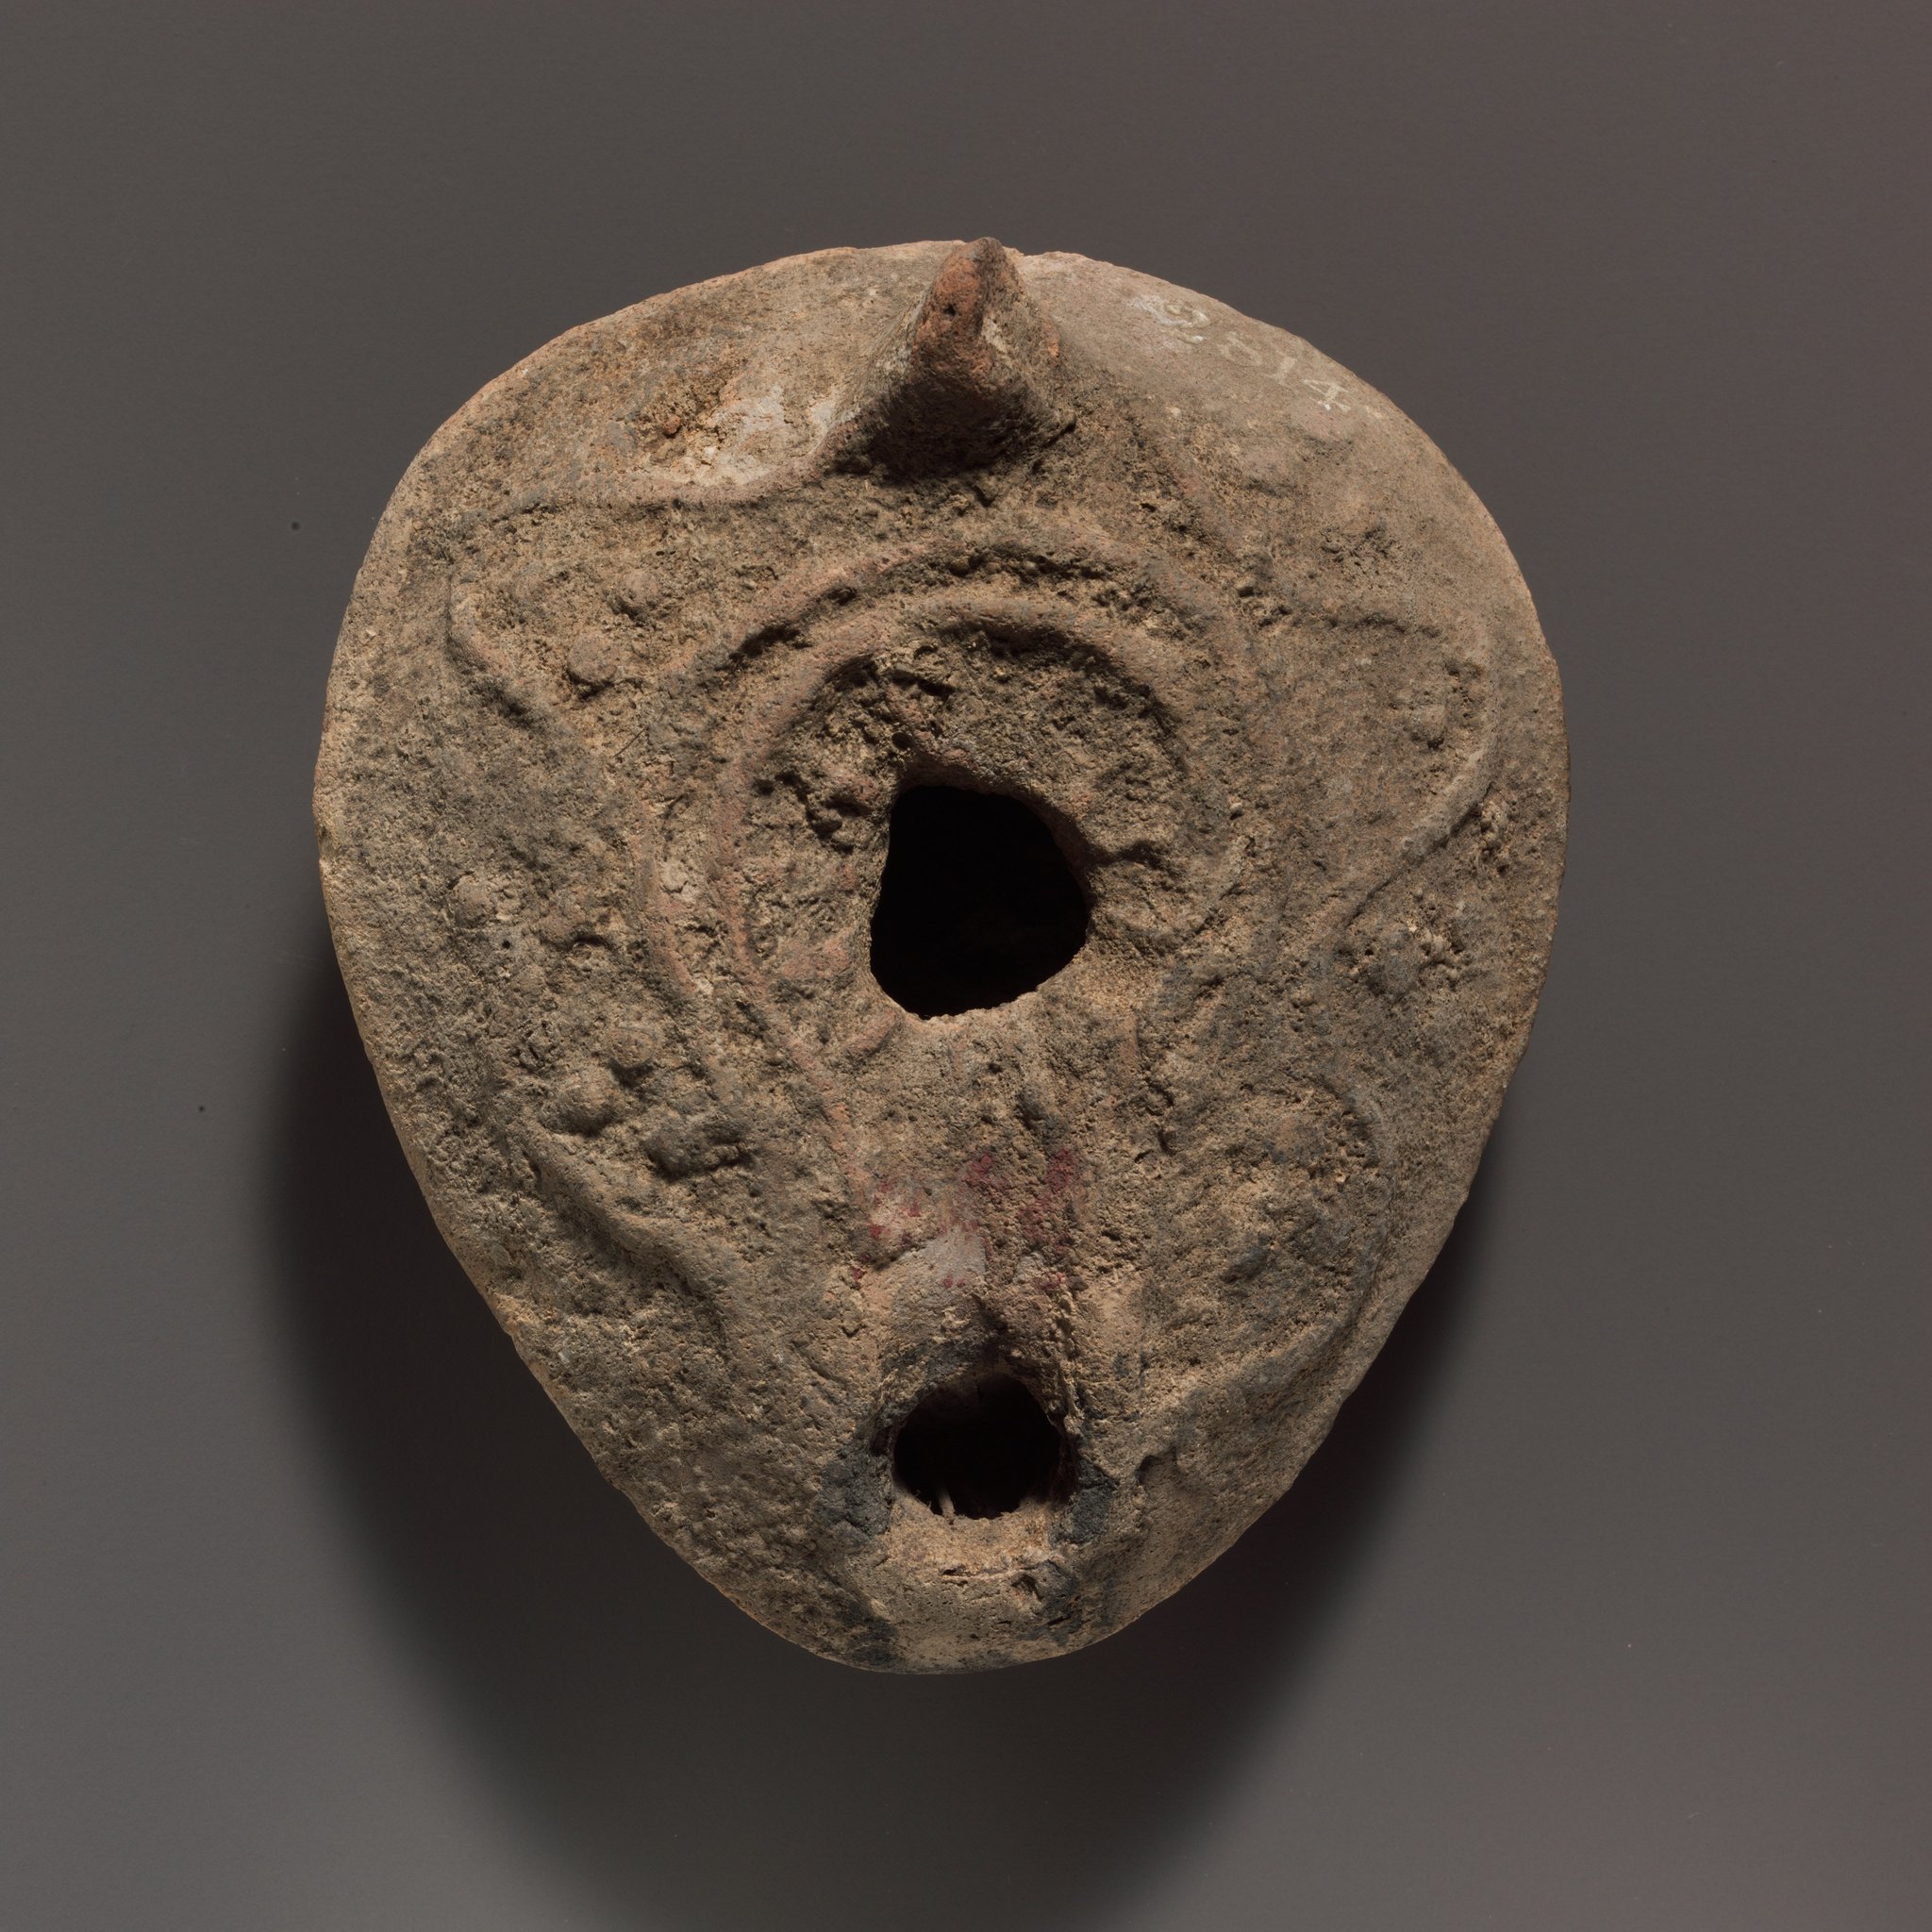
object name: lamp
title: Terracotta oil lamp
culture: roman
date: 601-700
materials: terracotta